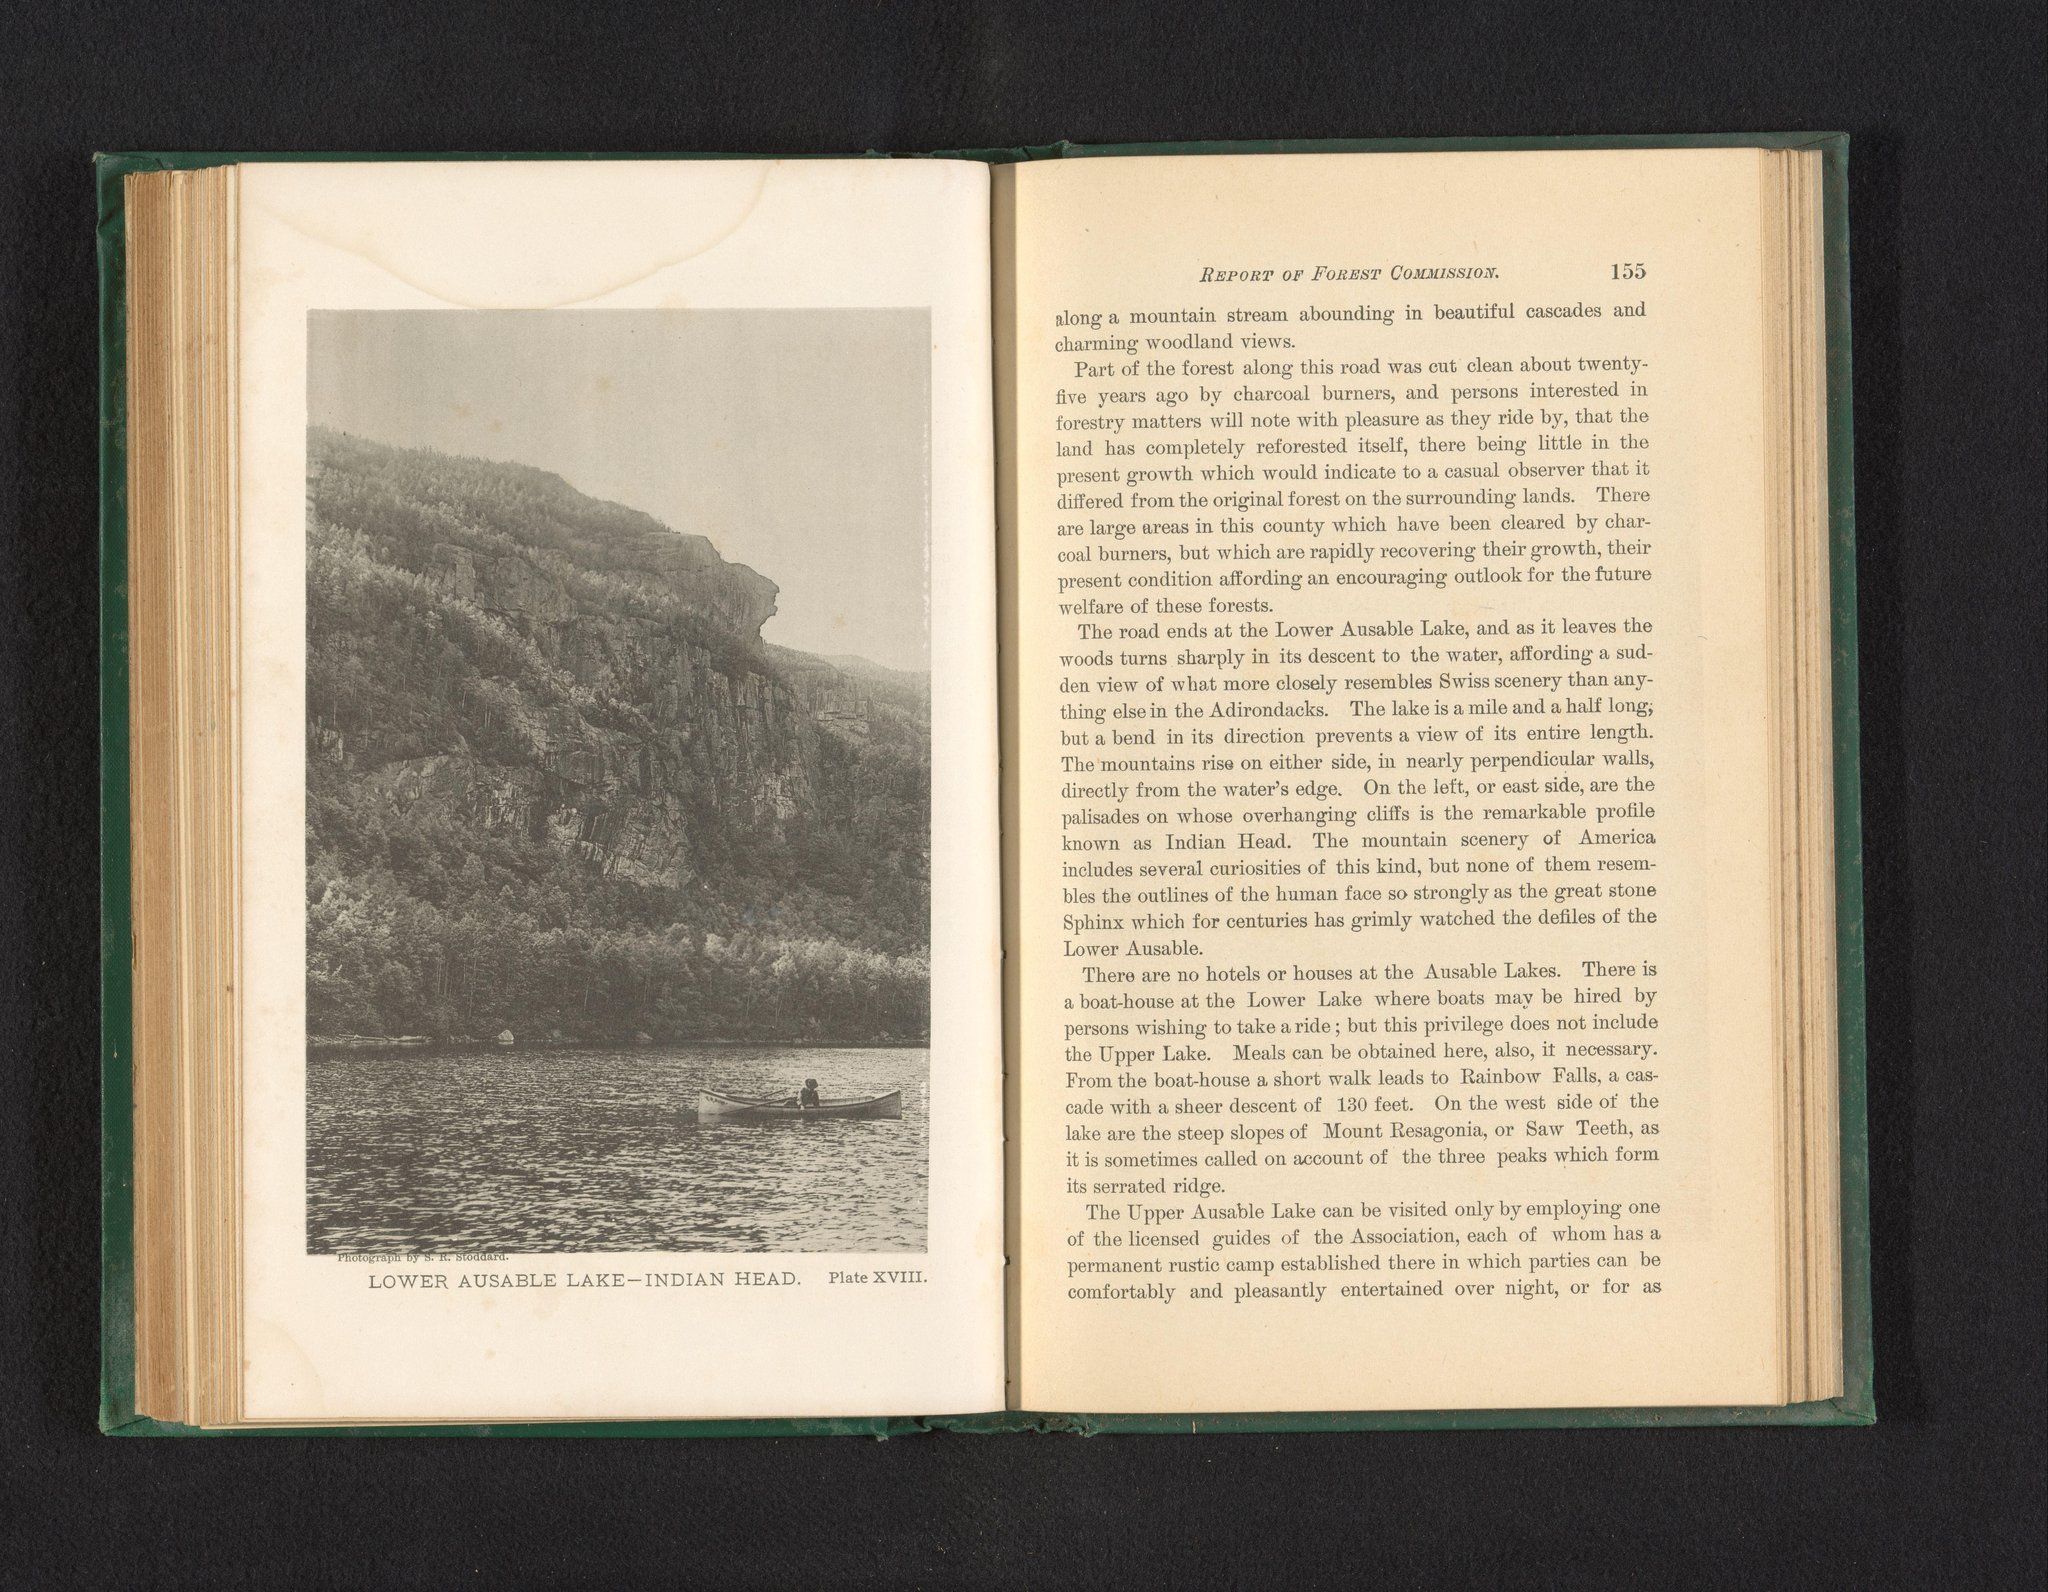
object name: photomechanical print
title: Lower Ausable Lake-Indian Head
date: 1891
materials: paper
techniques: photograph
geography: new york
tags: lake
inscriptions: number: ‘Plate XVIII.’